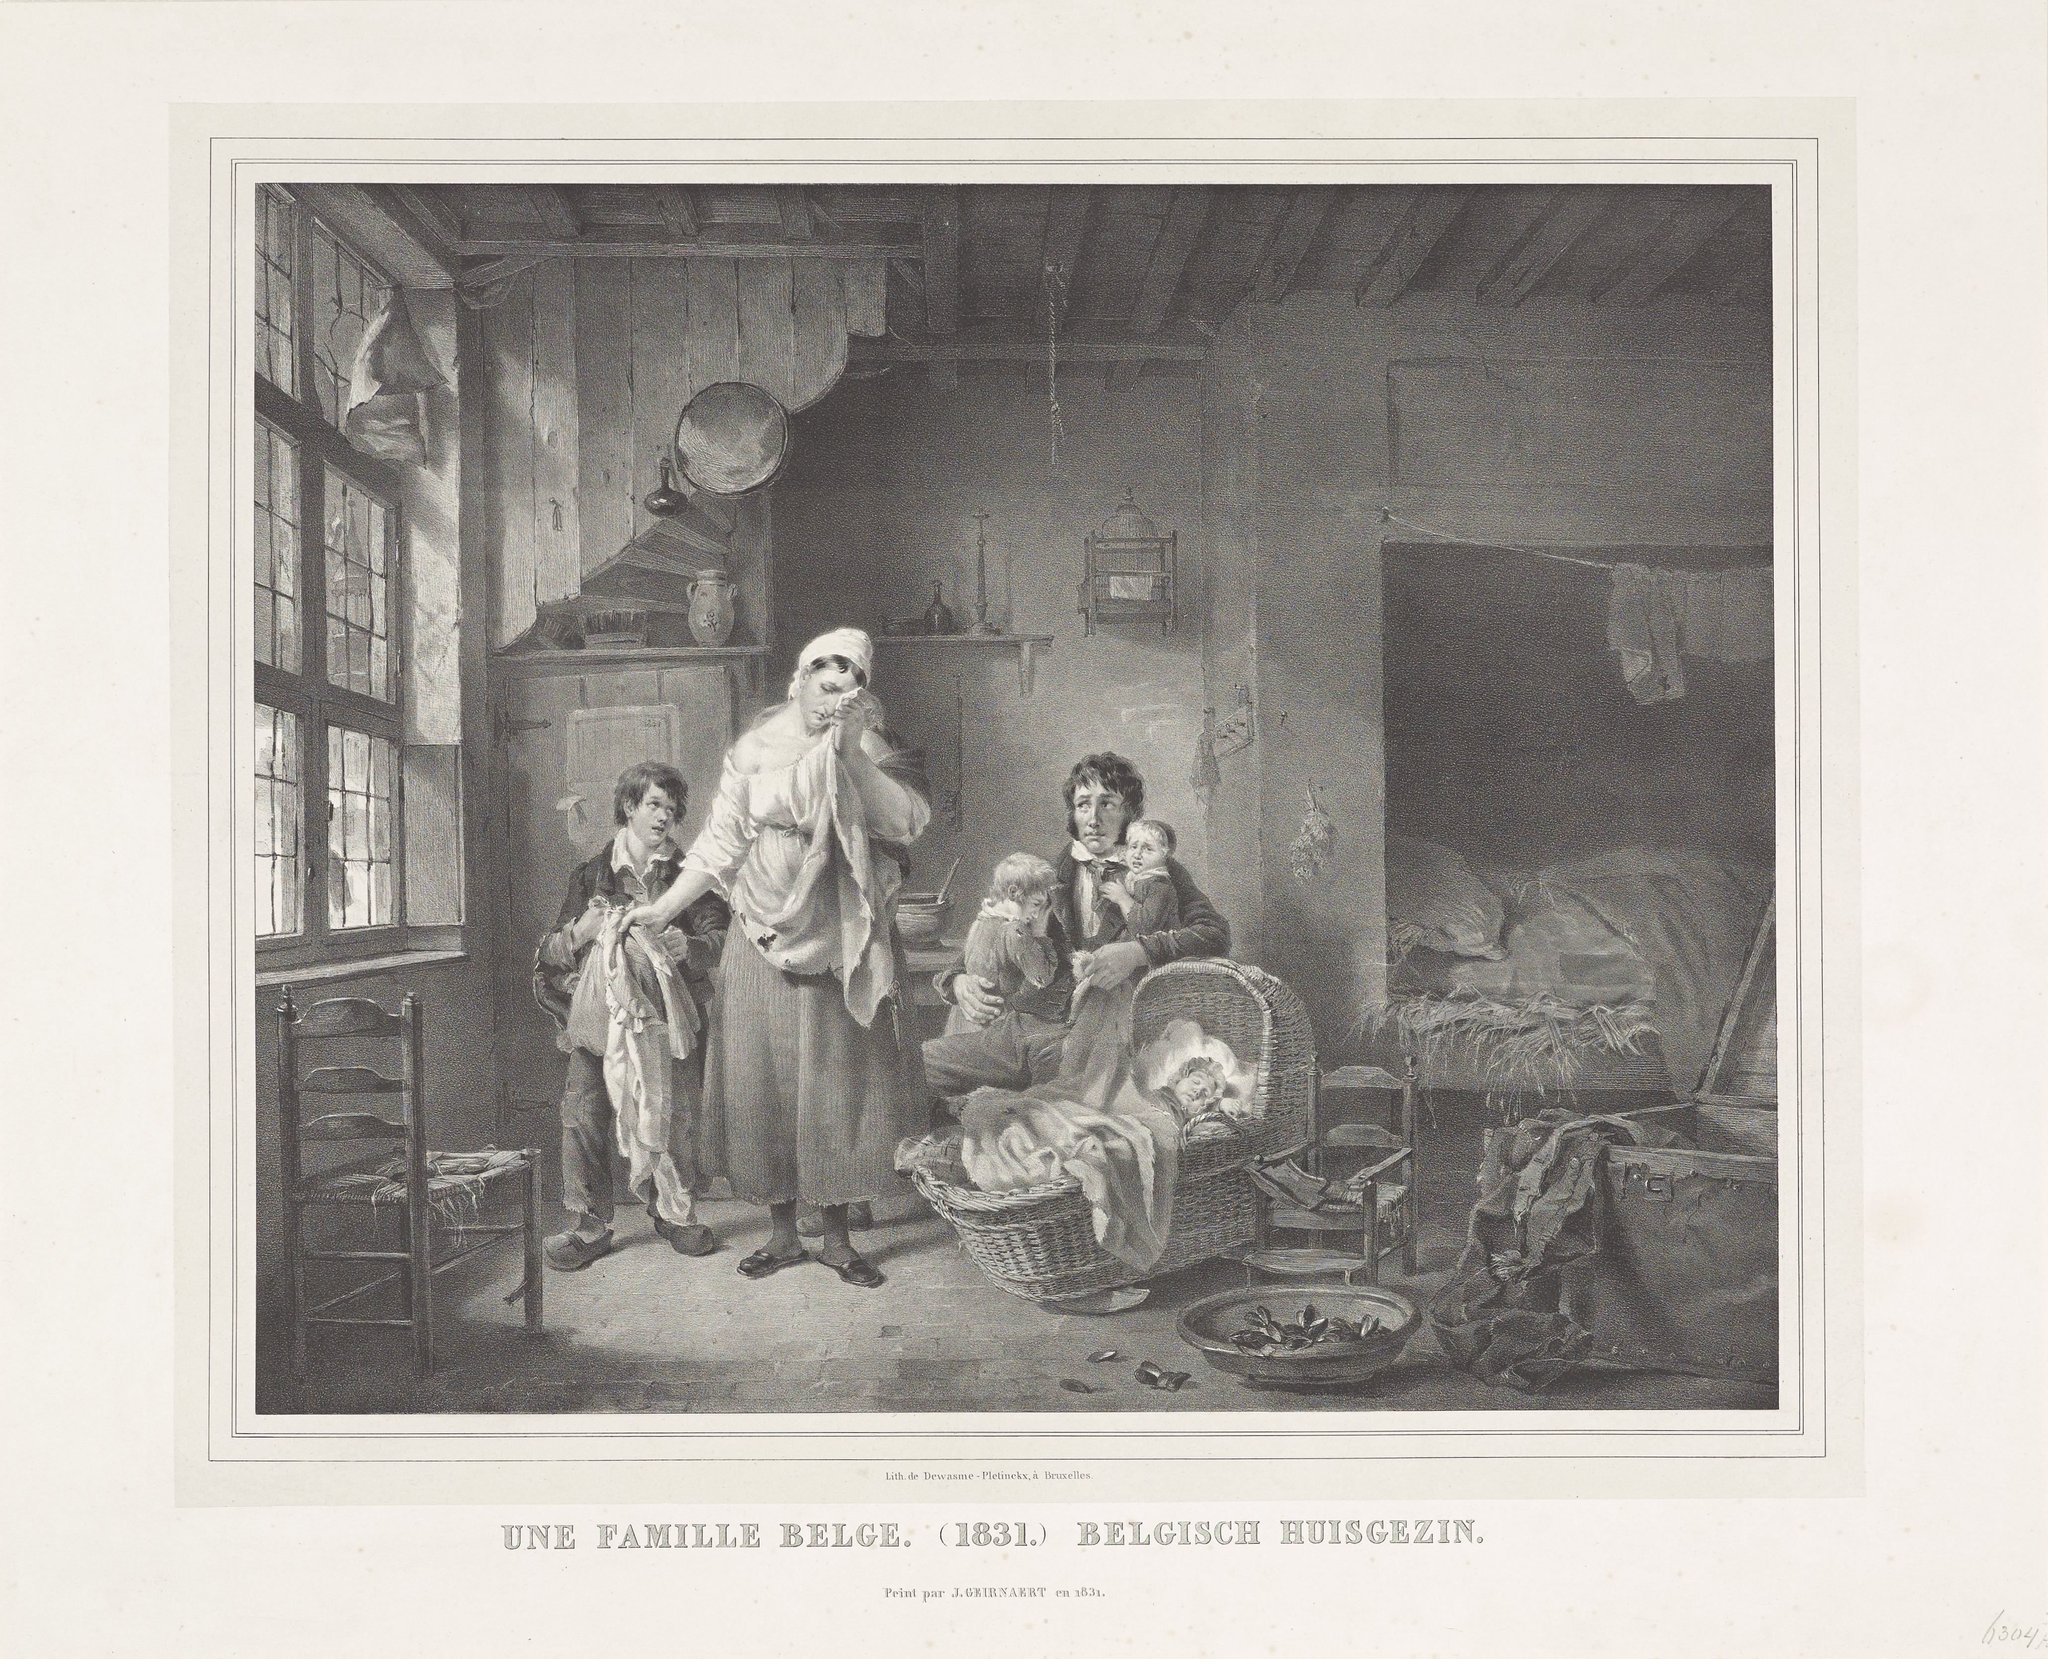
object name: print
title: Une Famille Belge. (1831.) Belgisch Huisgezin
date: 1831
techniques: printmaking, lithograph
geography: belgium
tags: contrast between rich and poor, family life at home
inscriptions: collector's mark: Lugt 2228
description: Interieur van een woning met een ongelukkige Belgische familie in armoede. Toestand in 1831, na de onafhankelijkheid. Onderdeel van een serie van vier spotprenten uit 1831 op de toestand in België vóór en na de afscheiding, Zie ook de pendant.